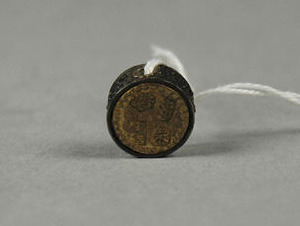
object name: ojime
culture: japanese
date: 1801-1900